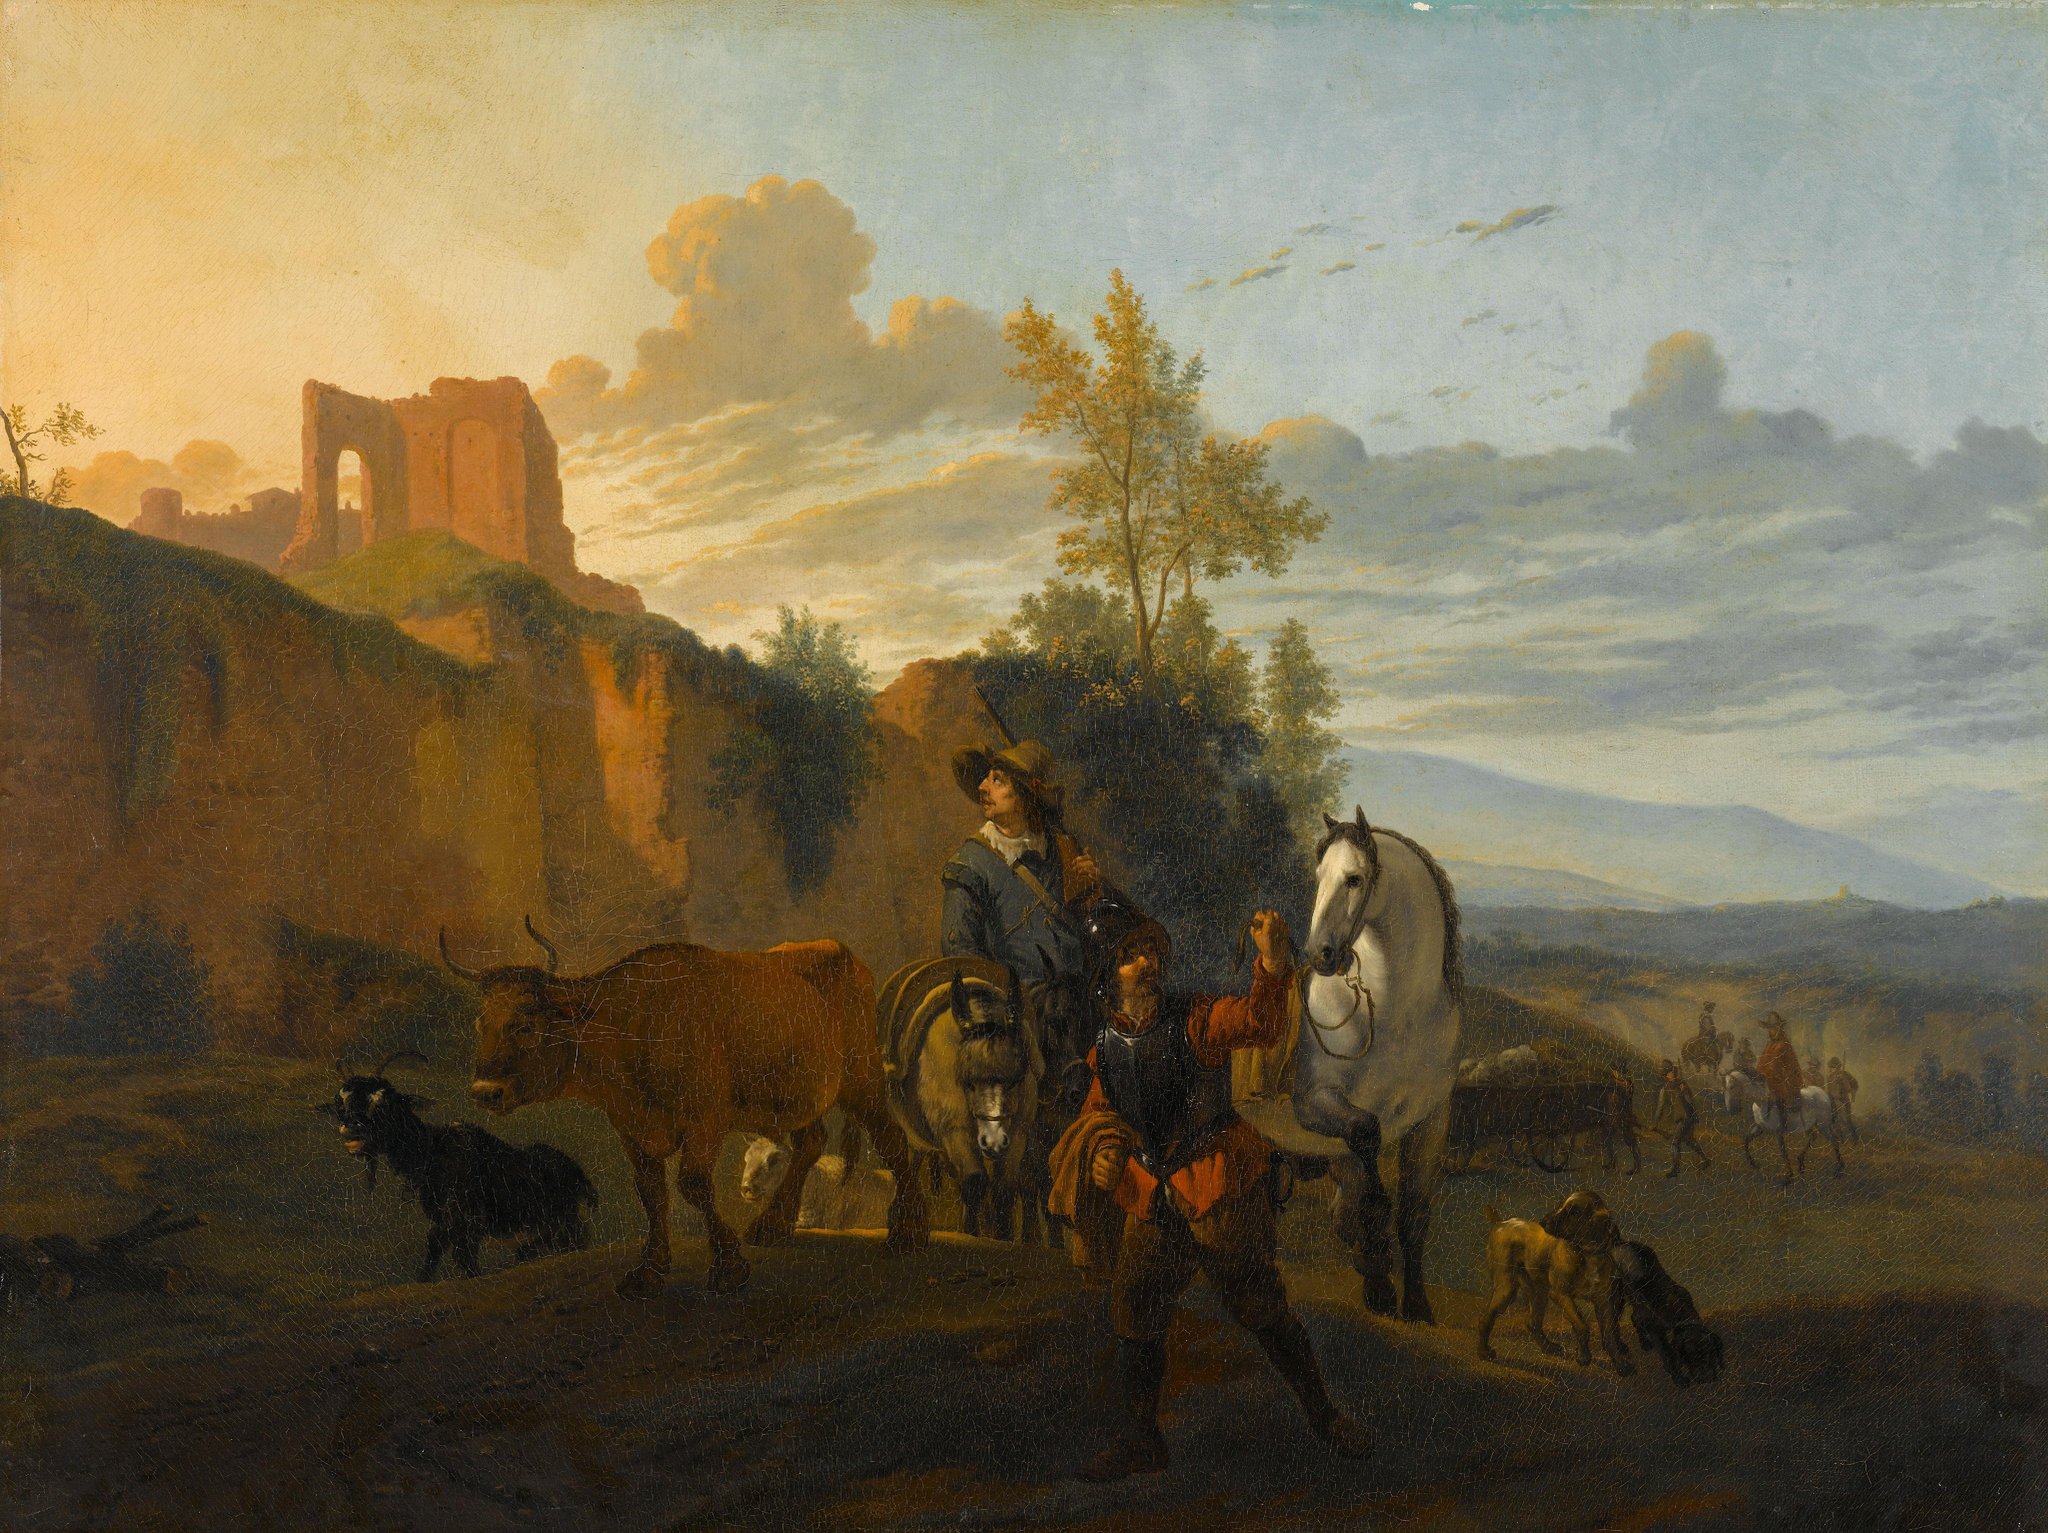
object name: painting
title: Italian Landscape with Soldiers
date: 1652-1700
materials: canvas, oil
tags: herding, herdsman, herdswoman, shepherd, shepherdess, cowherd, etc., landscape with ruins, occupations ~ cattle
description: Italiaans landschap met soldaten, paarden en vee bij een ruïne. Kopie naar het origineel 'De voorwacht van het Konvooi' uit 1652 te Brussel.